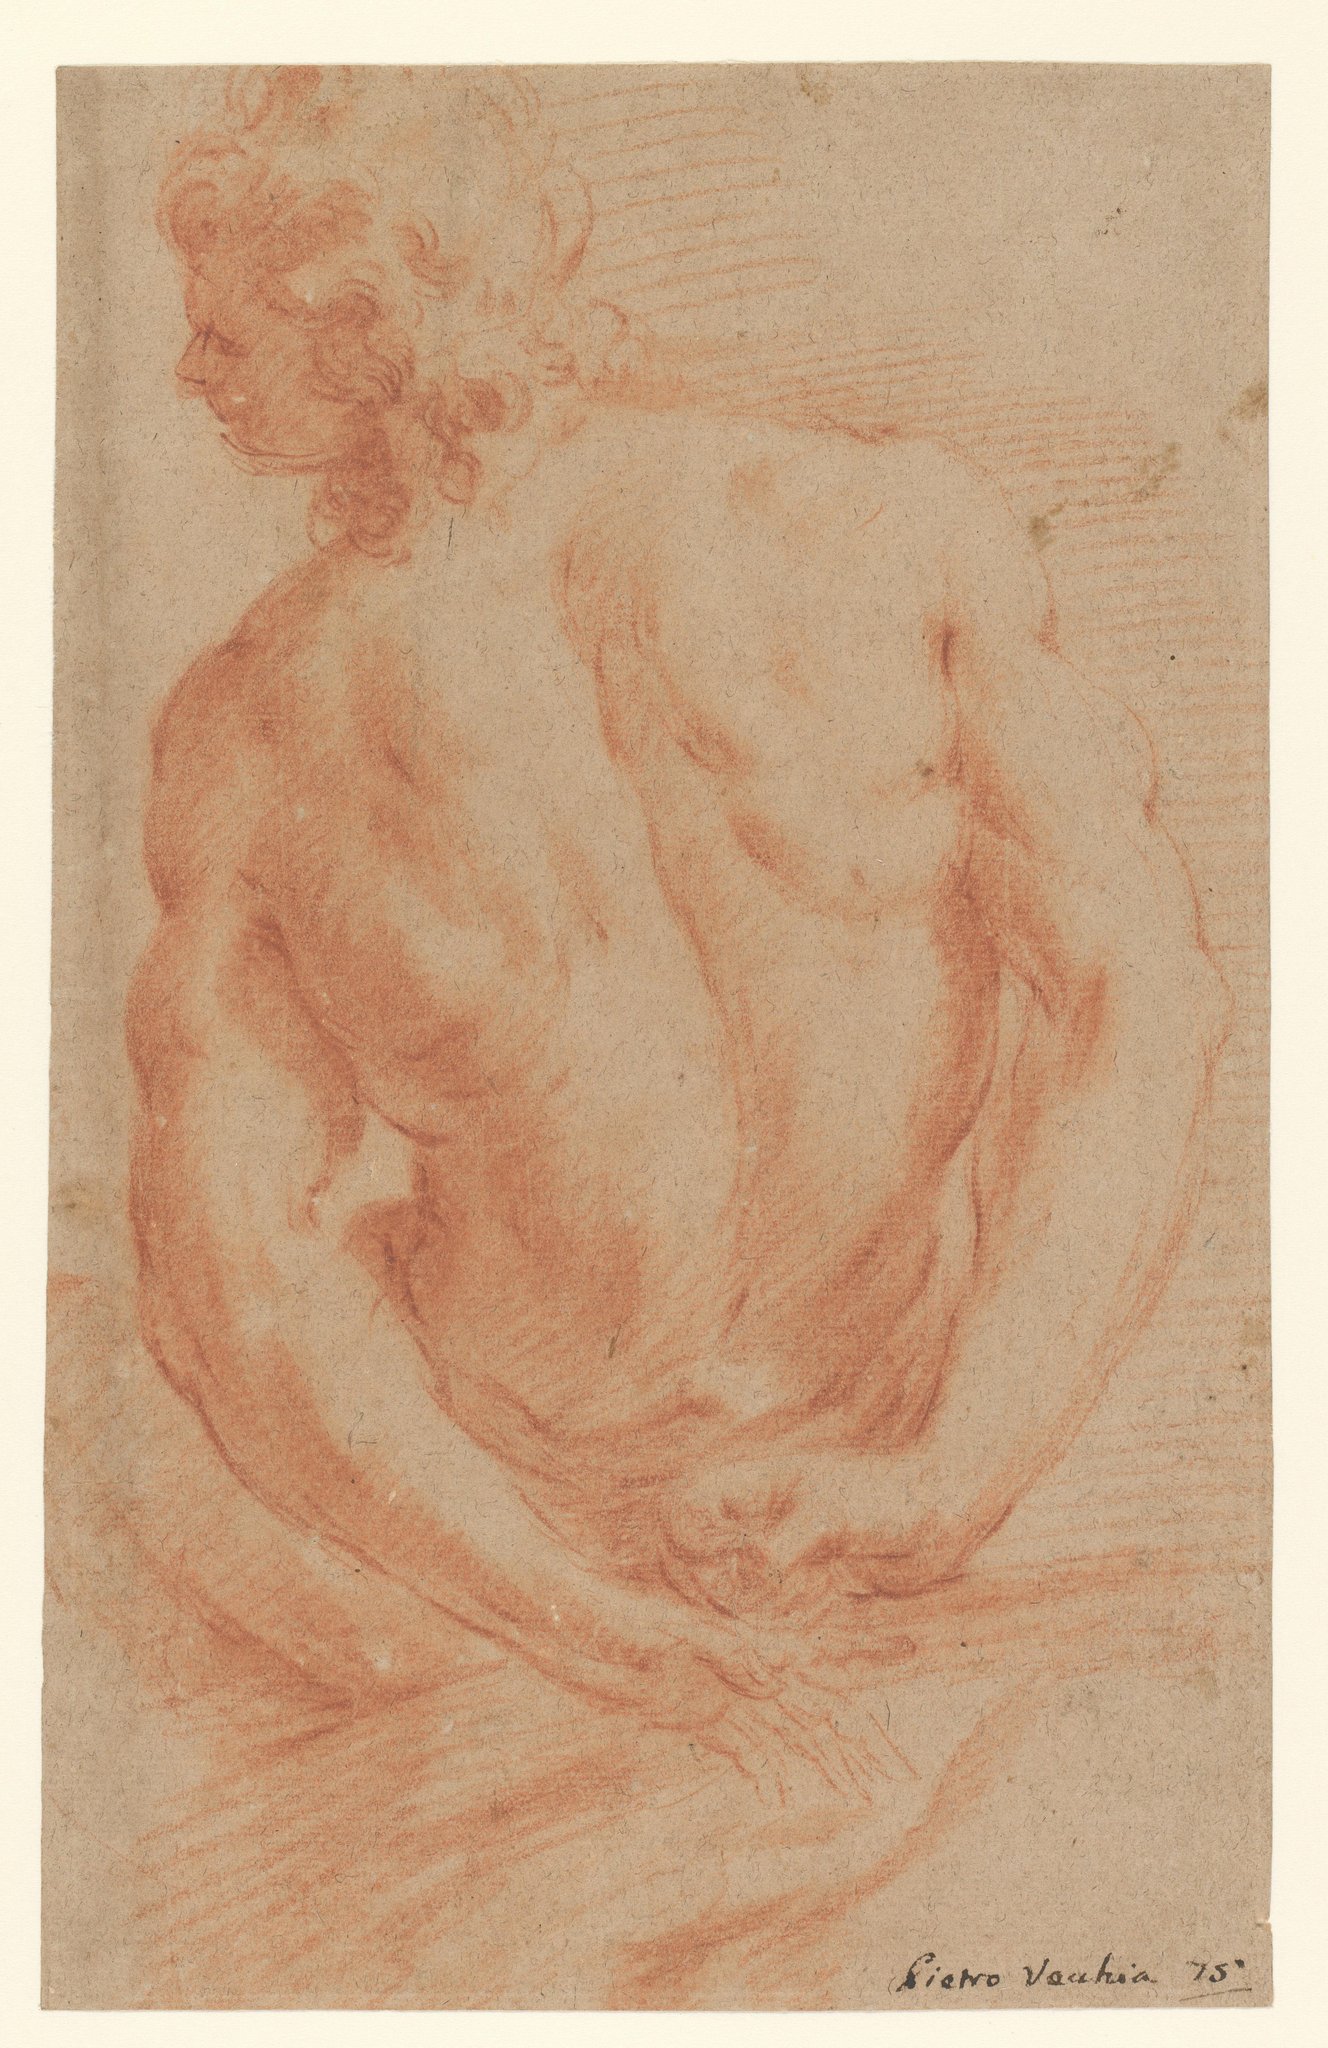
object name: drawing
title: Studie van een mannelijk naakt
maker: pietro della vecchia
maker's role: draughtsman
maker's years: 1605-1678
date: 1643-1663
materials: chalk, paper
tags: sitting figure, arm or hand bent behind the body - aa - both arms or hands, back, torso